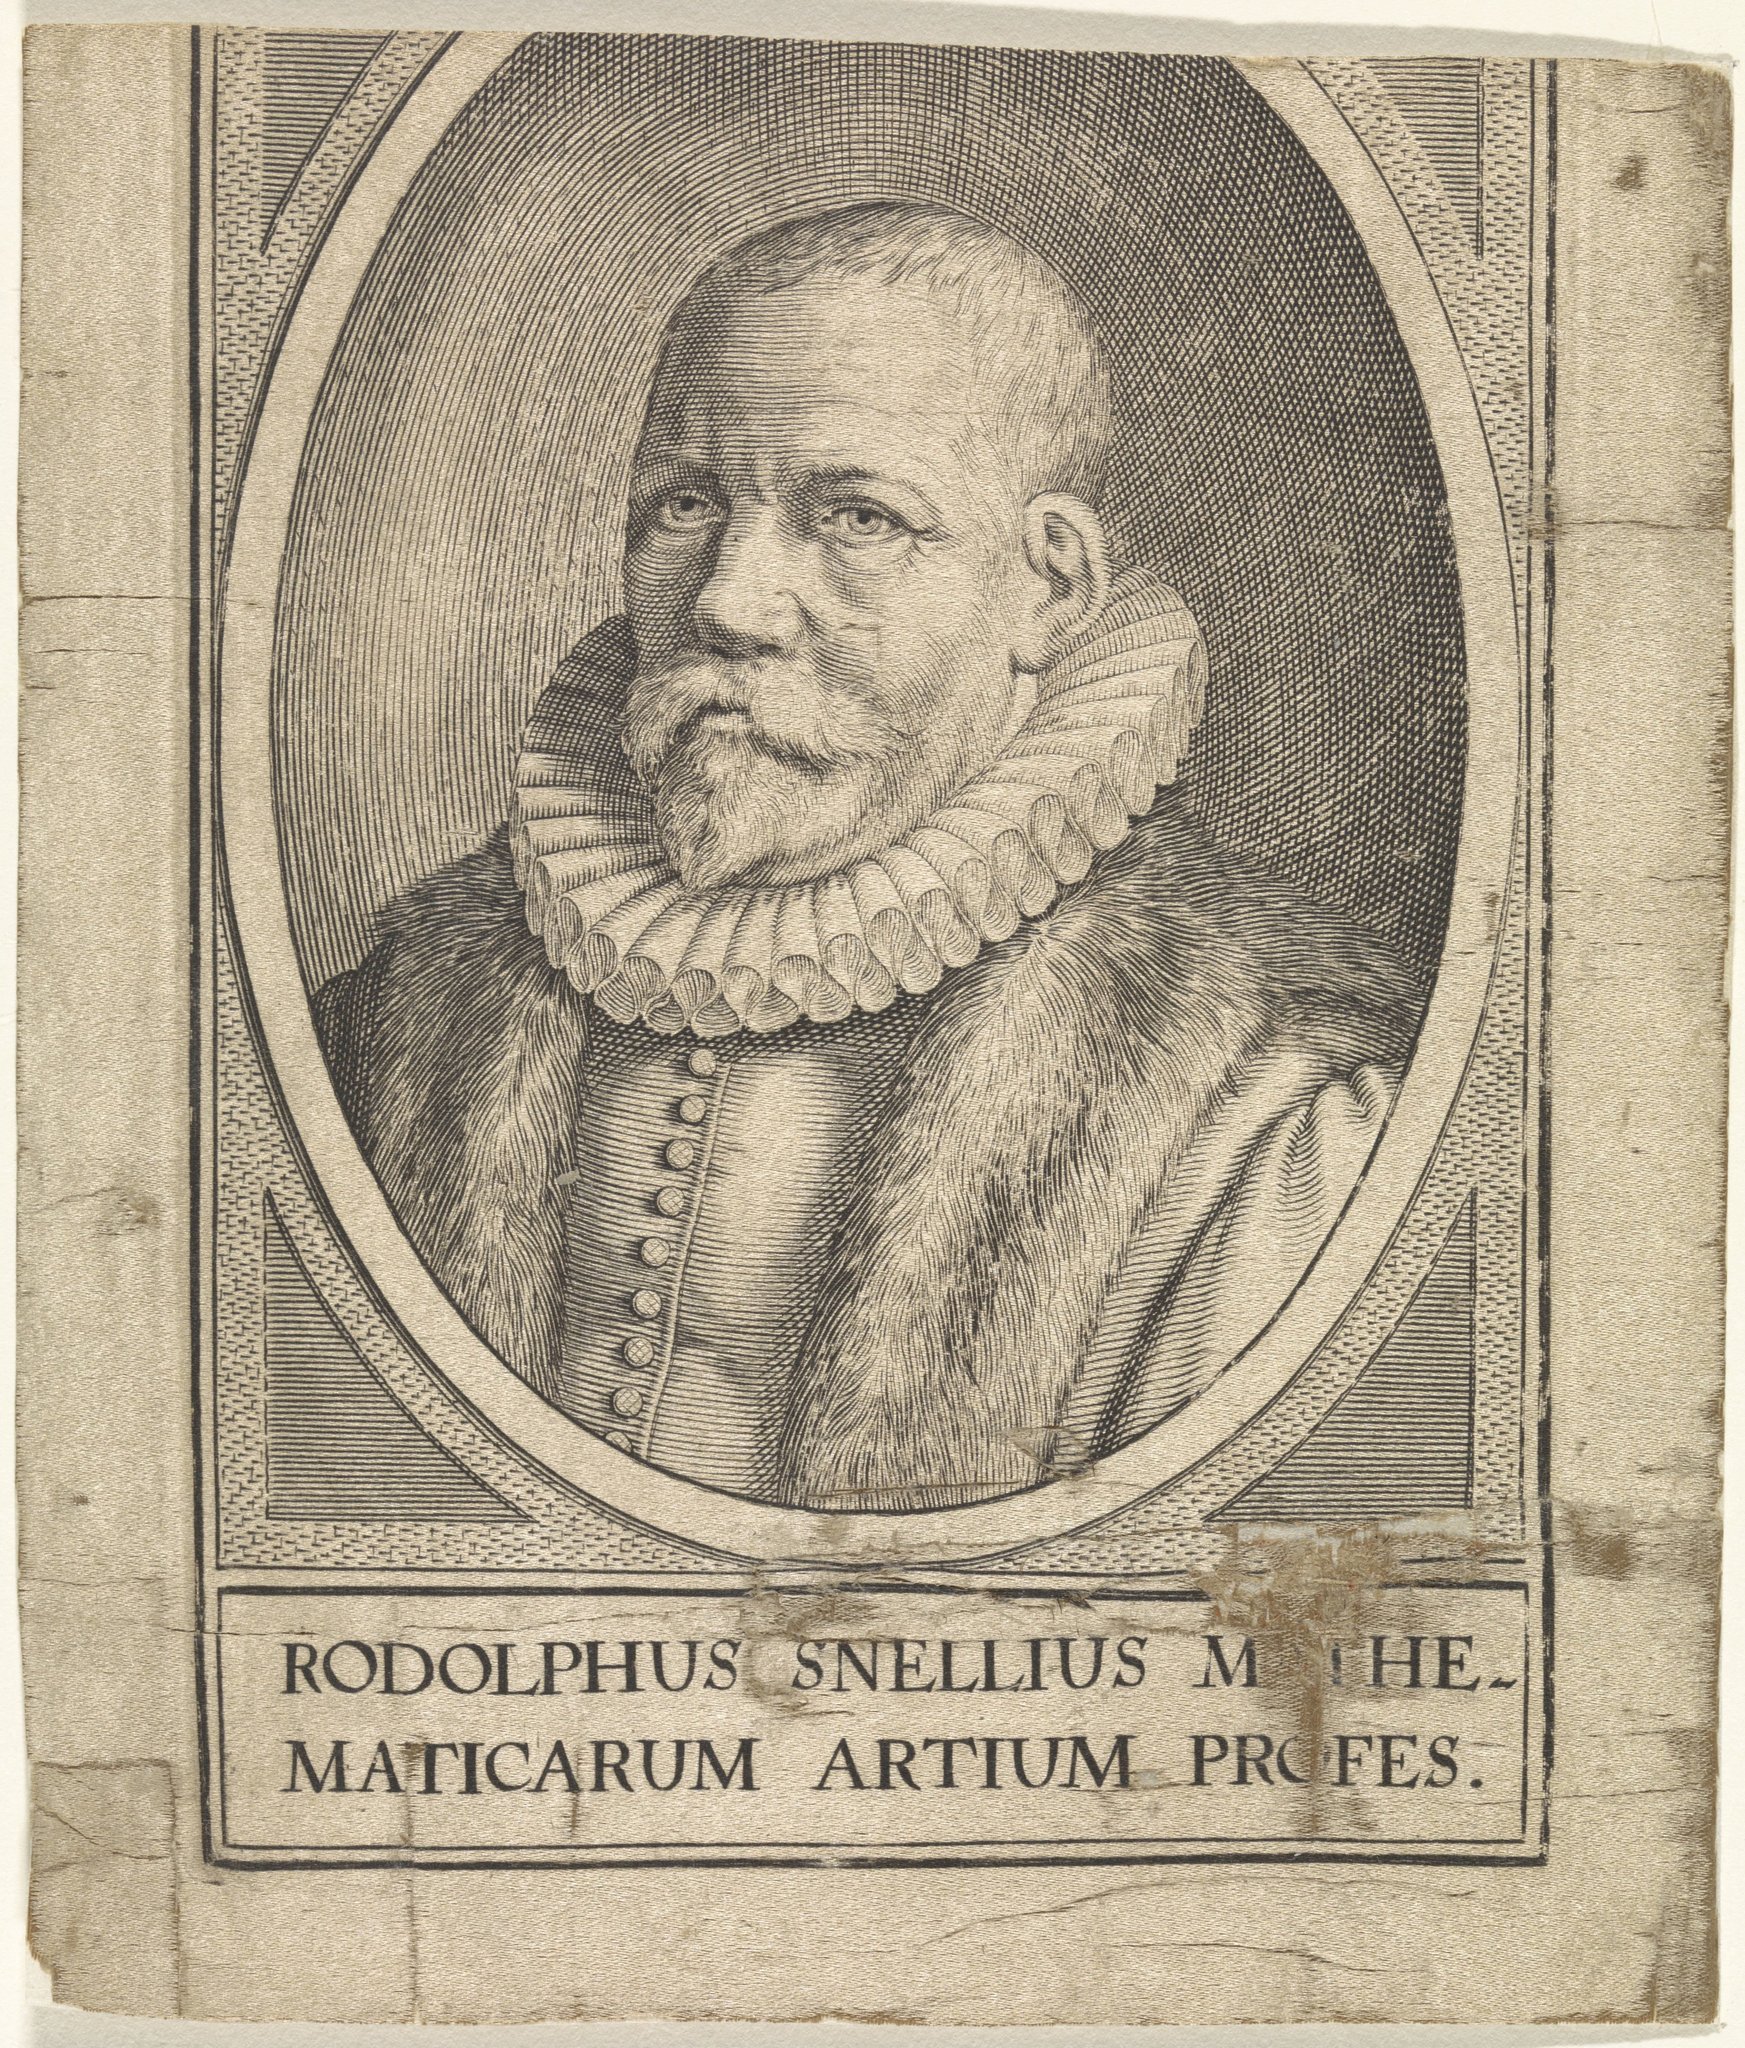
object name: print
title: Portret van Rudolph Snellius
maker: de passe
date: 1625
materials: silk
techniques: engraving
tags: mathematicus, rudolph snellius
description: Prent mogelijk ook als boekillustratie in: Meursius, Joannes. Athenæ Batavæ. Sive, De vrbe Leidensi, & academiâ, virisque claris. Leiden: Andries Clouck, Bonaventura en Abraham Elzevier, 1625.